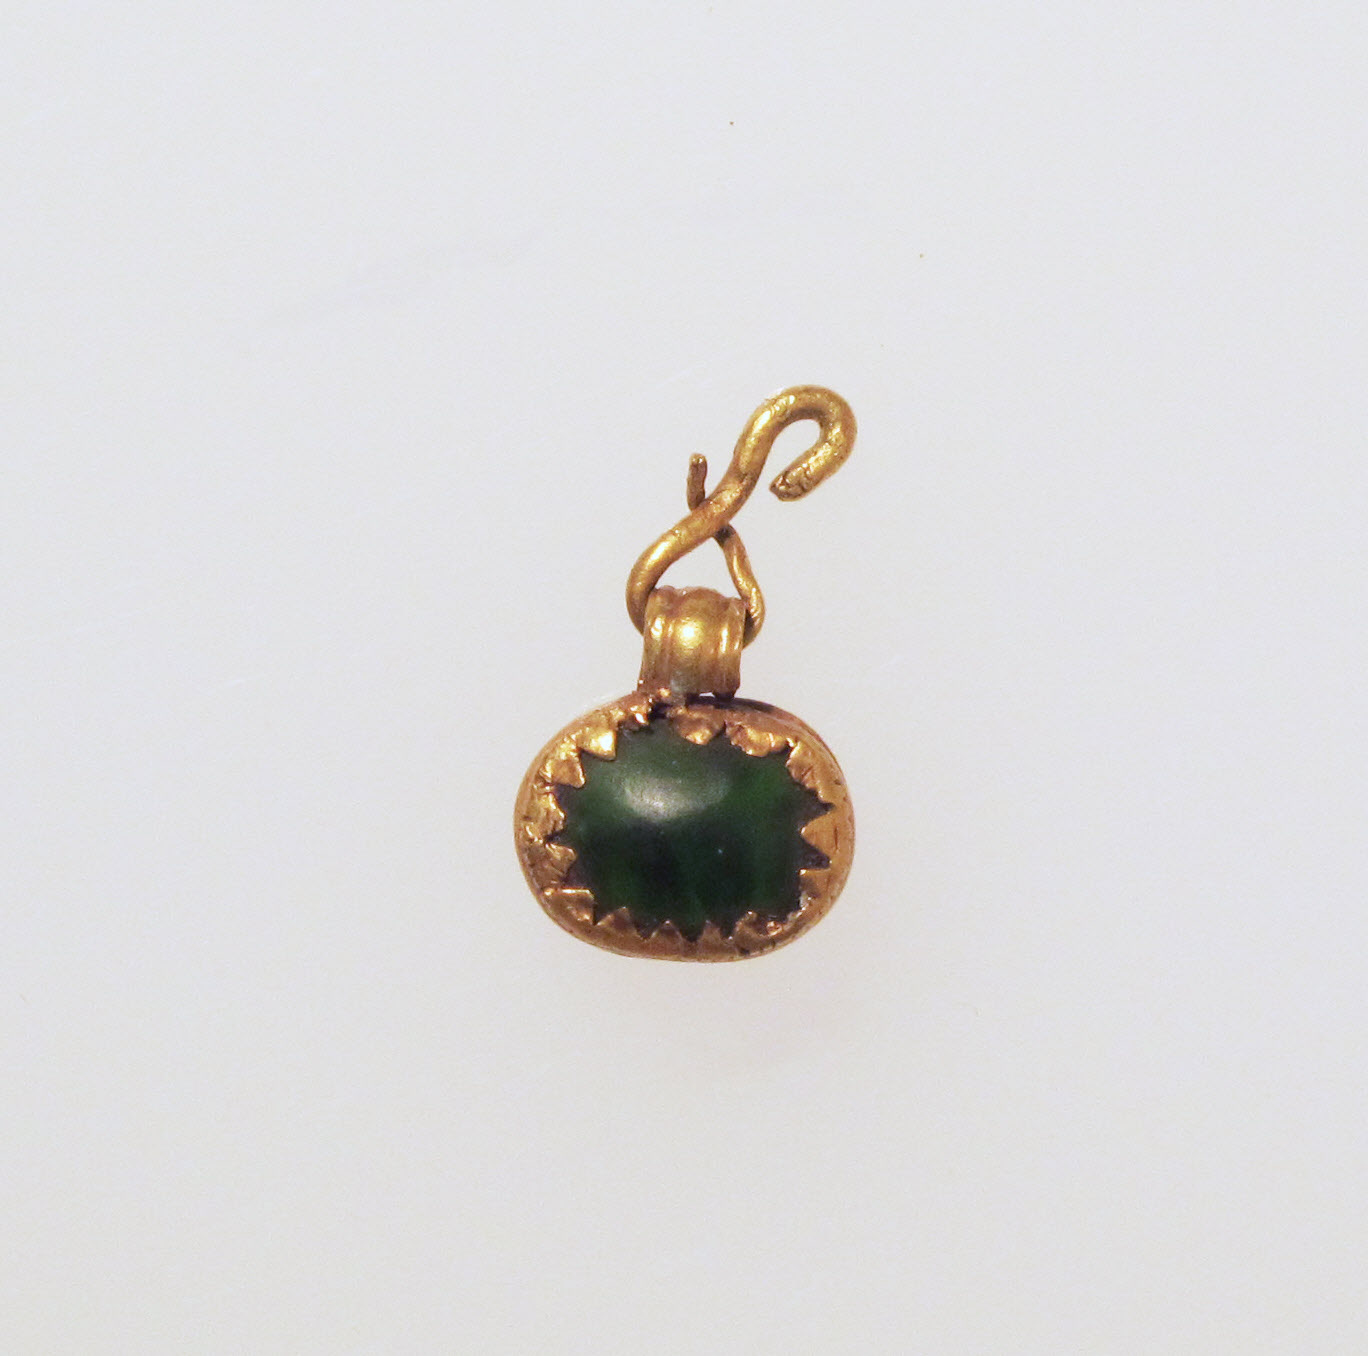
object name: ring with scaraboid pendant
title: Pendant with scaraboid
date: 7000 BCE-330 CE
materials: glass, gold, paste